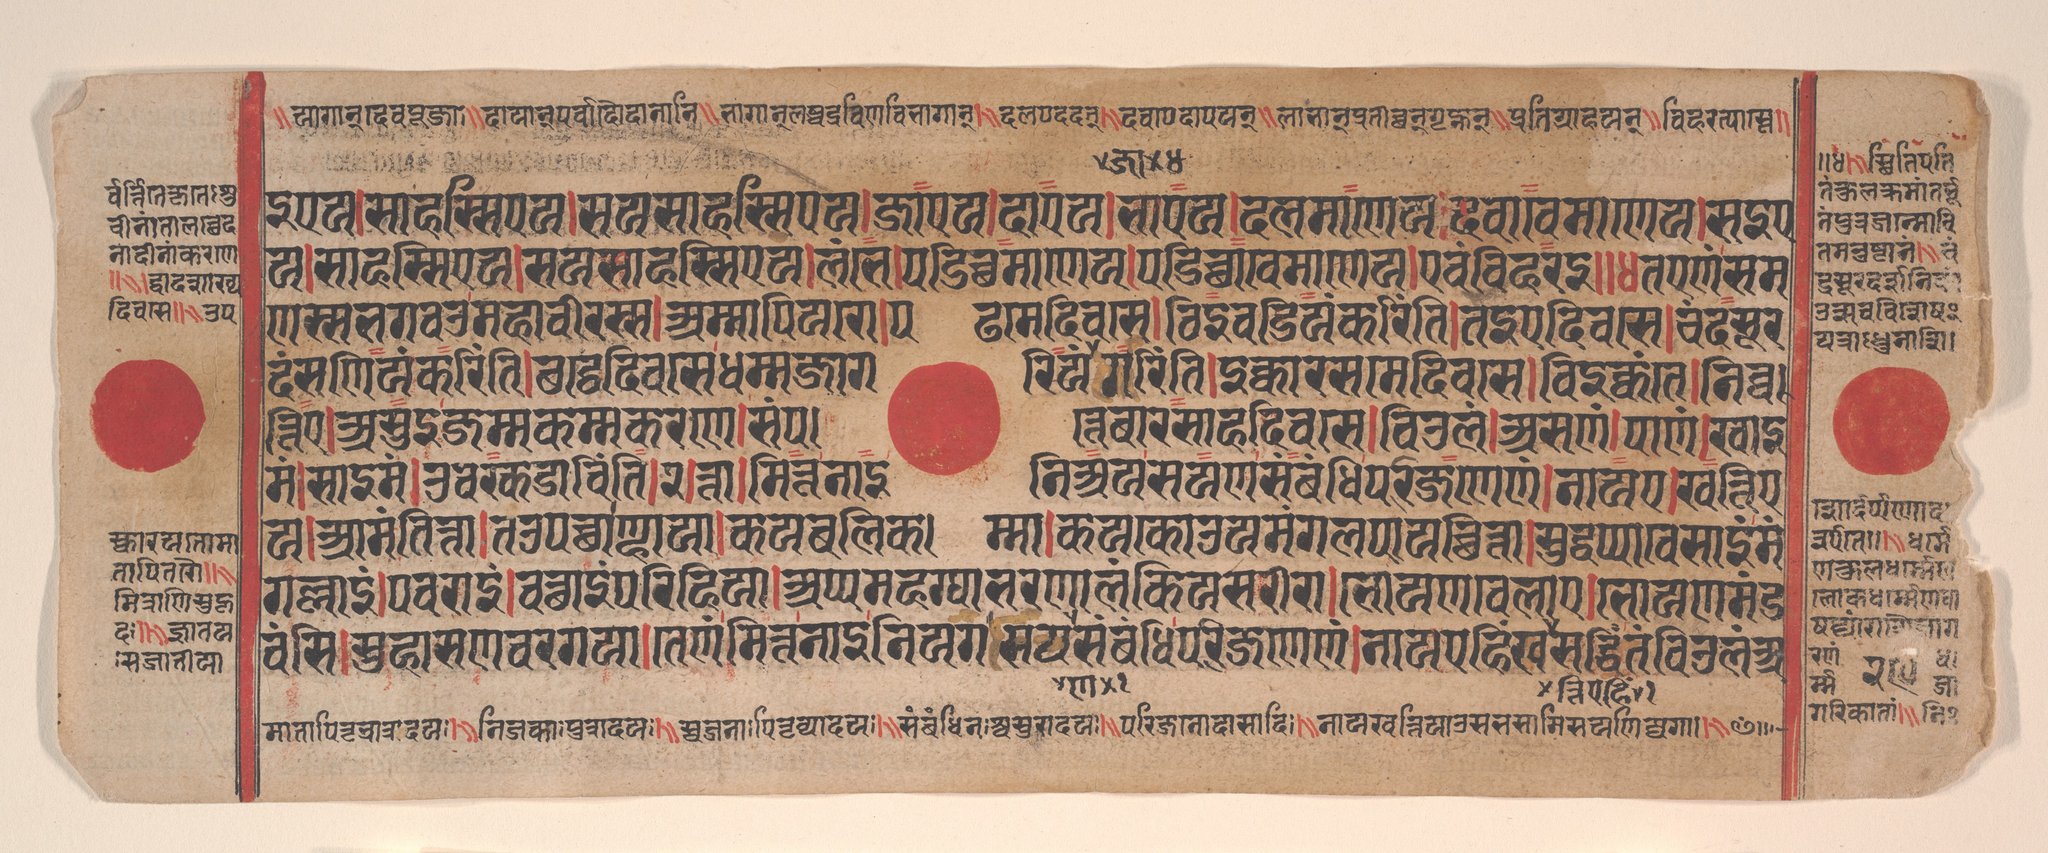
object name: folio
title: Leaf from a Kalpa Sutra (Jain Book of Rituals)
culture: indian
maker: bhadrabahu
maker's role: artist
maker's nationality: indian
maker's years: 356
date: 1401-1500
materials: gold, ink, paper, watercolor